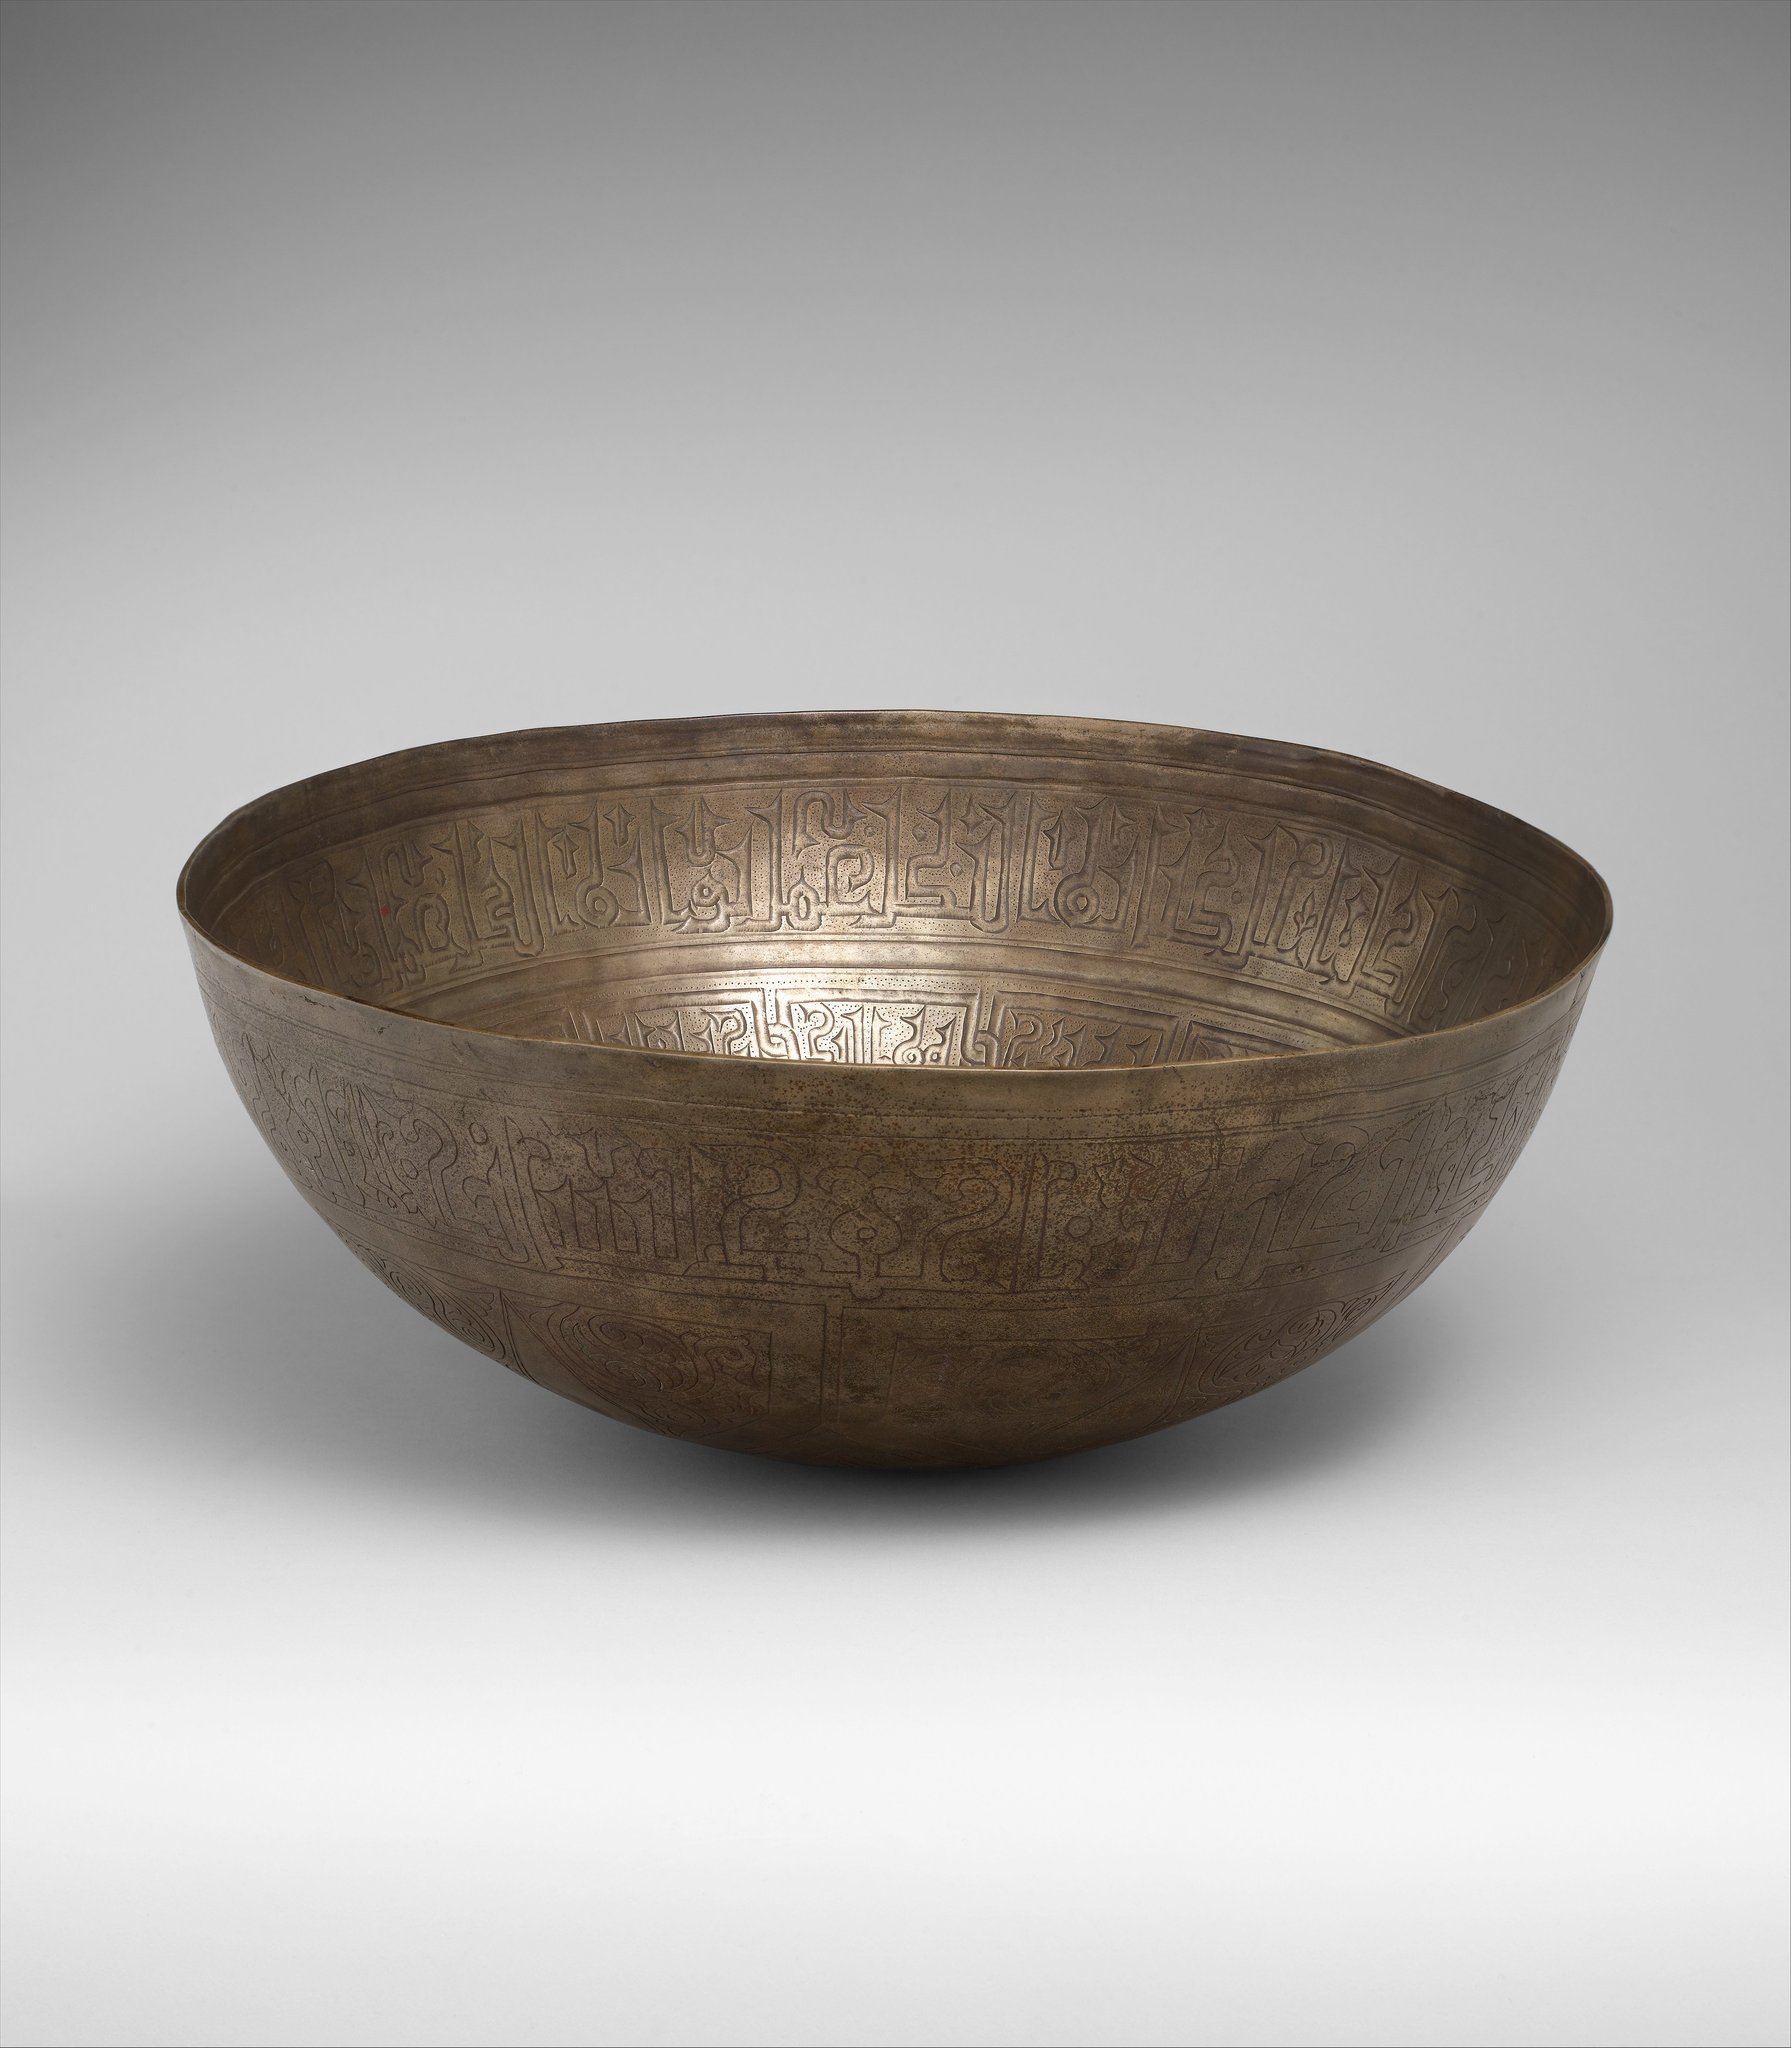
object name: bowl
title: High-Tin Bronze Bowl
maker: abu nasr al-naqqash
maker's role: maker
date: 1001-1100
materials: bronze, tin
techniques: casting, chasing, engraving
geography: afghanistan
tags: human figures,animals